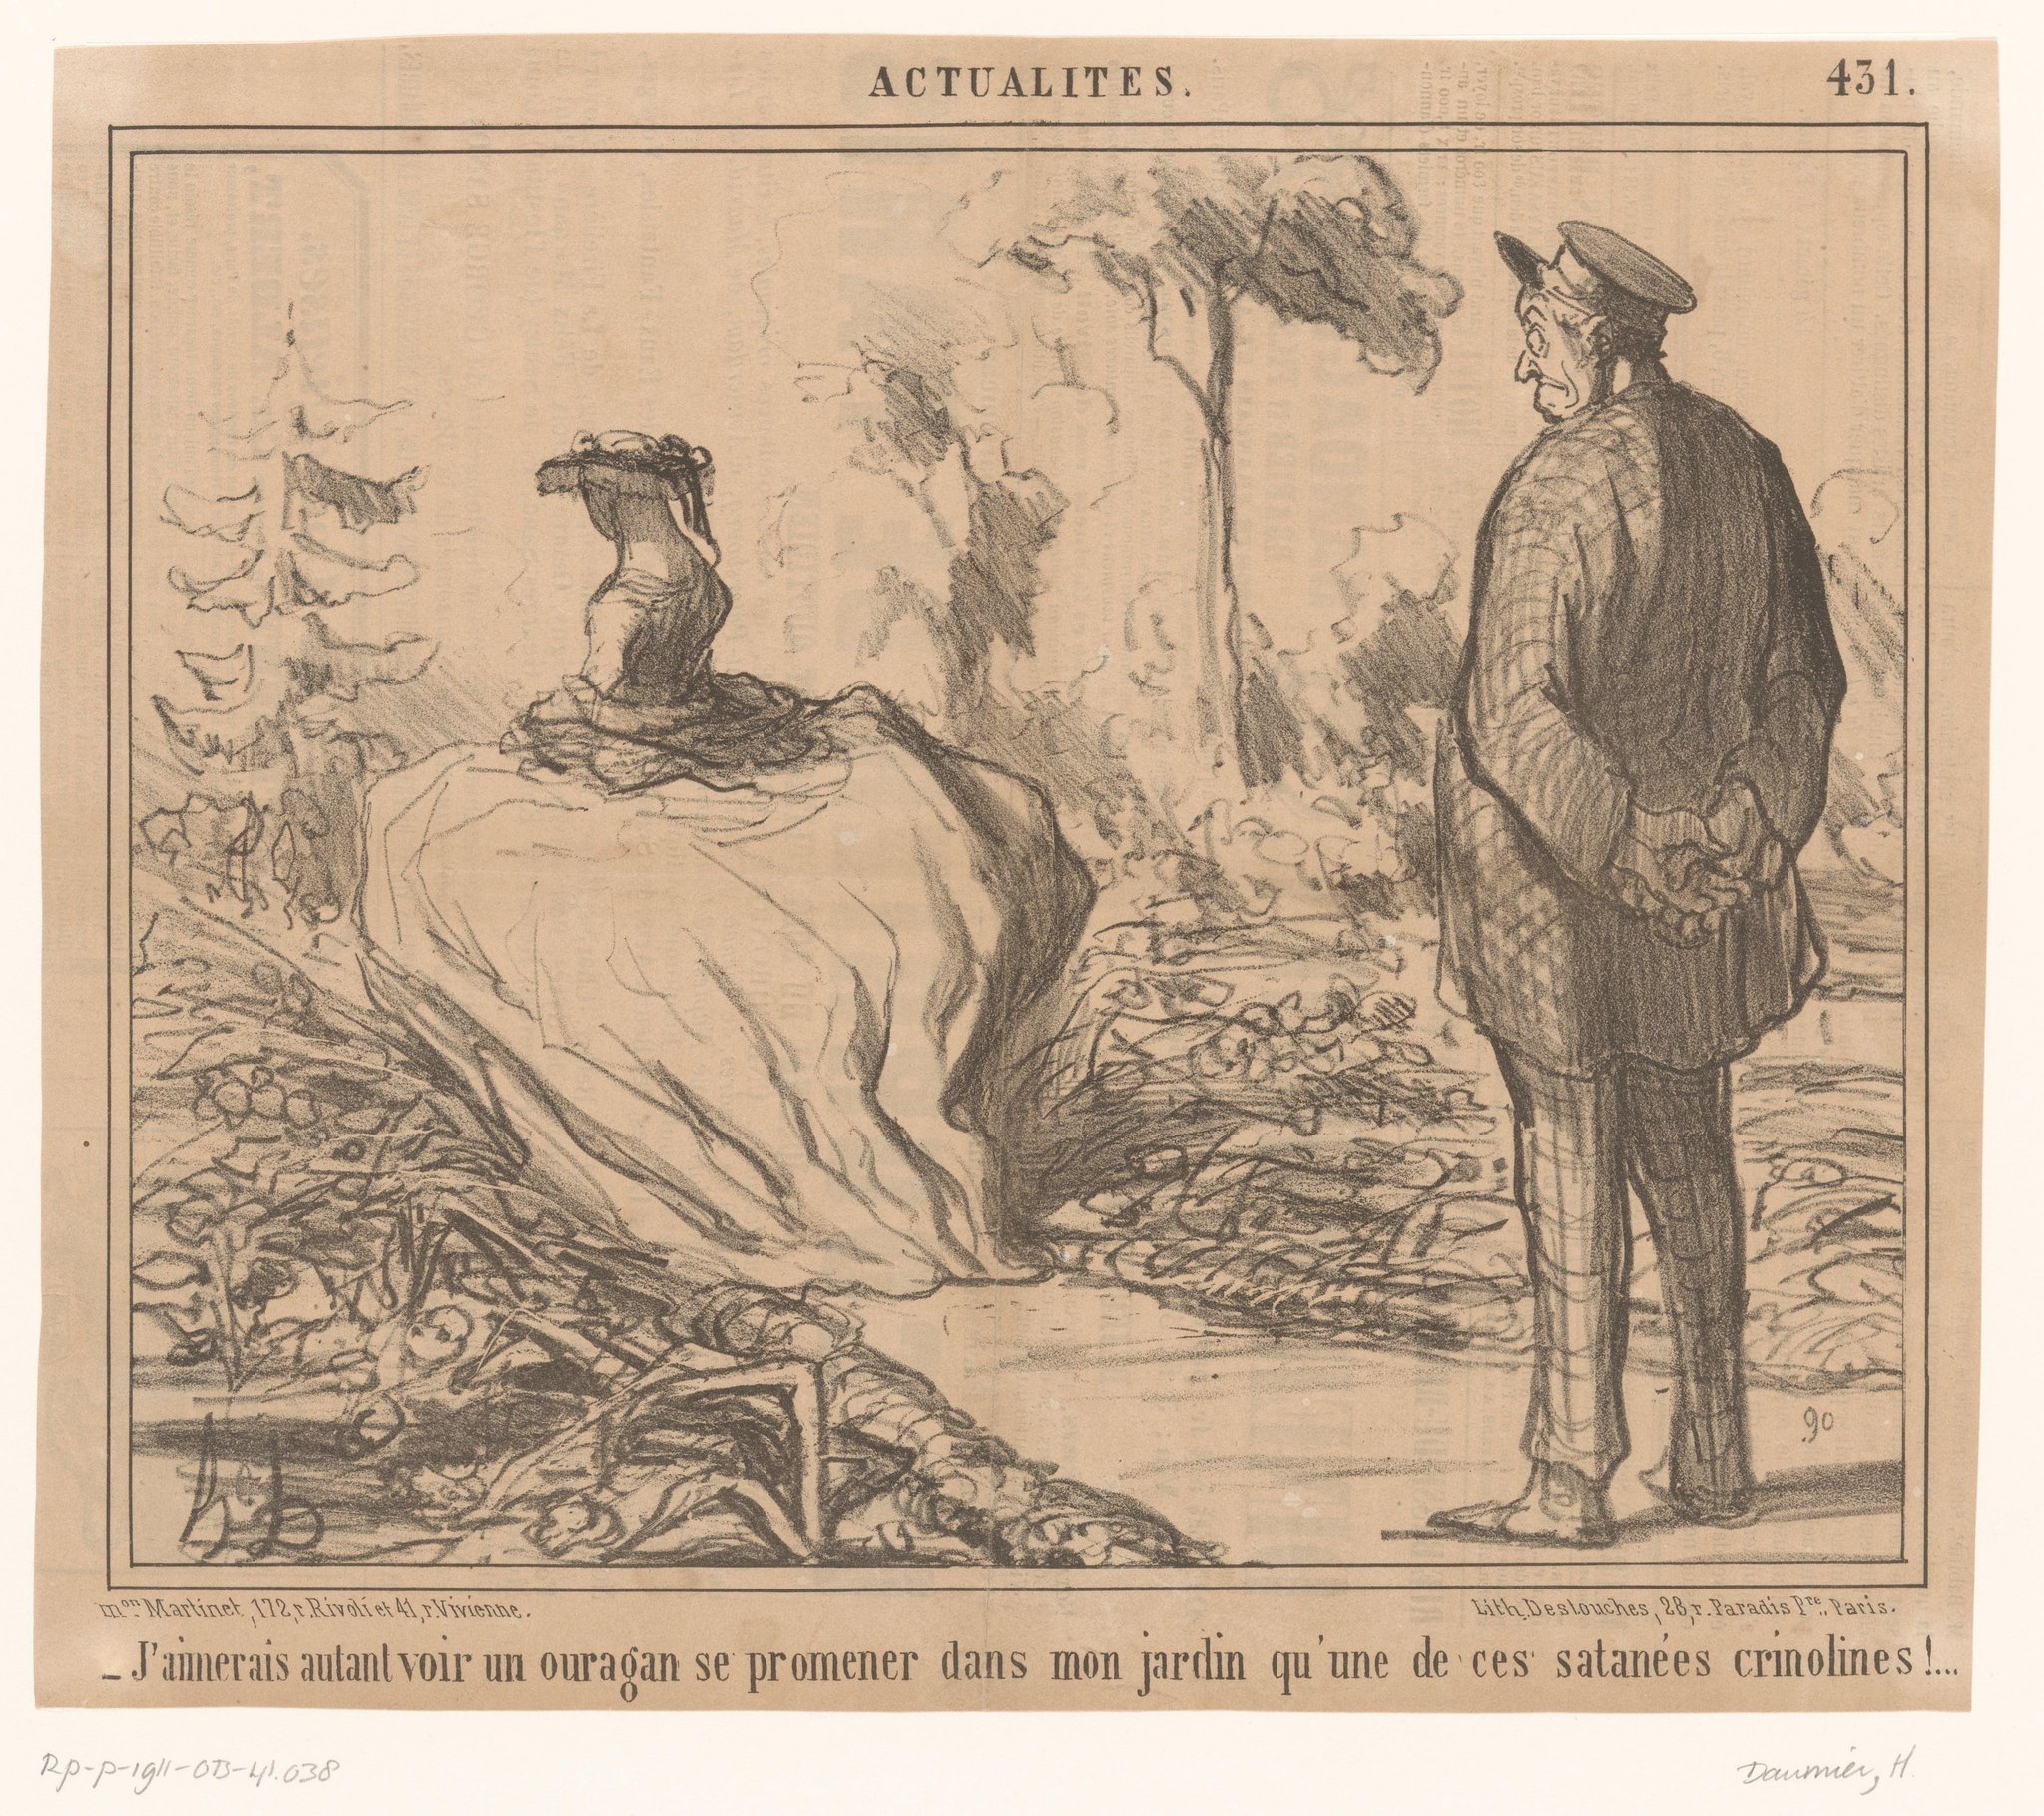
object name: cartoon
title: J'aimerais autant voir un ouragan se promener dans mon jardin (...)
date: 1857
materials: paper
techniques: lithograph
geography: paris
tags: caricatures (human types), garden, skirt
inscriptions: collector's mark: Lugt 2228a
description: De man zou liever een orkaan door zijn tuin zien gaan, dan een die 'vervloekte' crinolines (hoepelrokken).